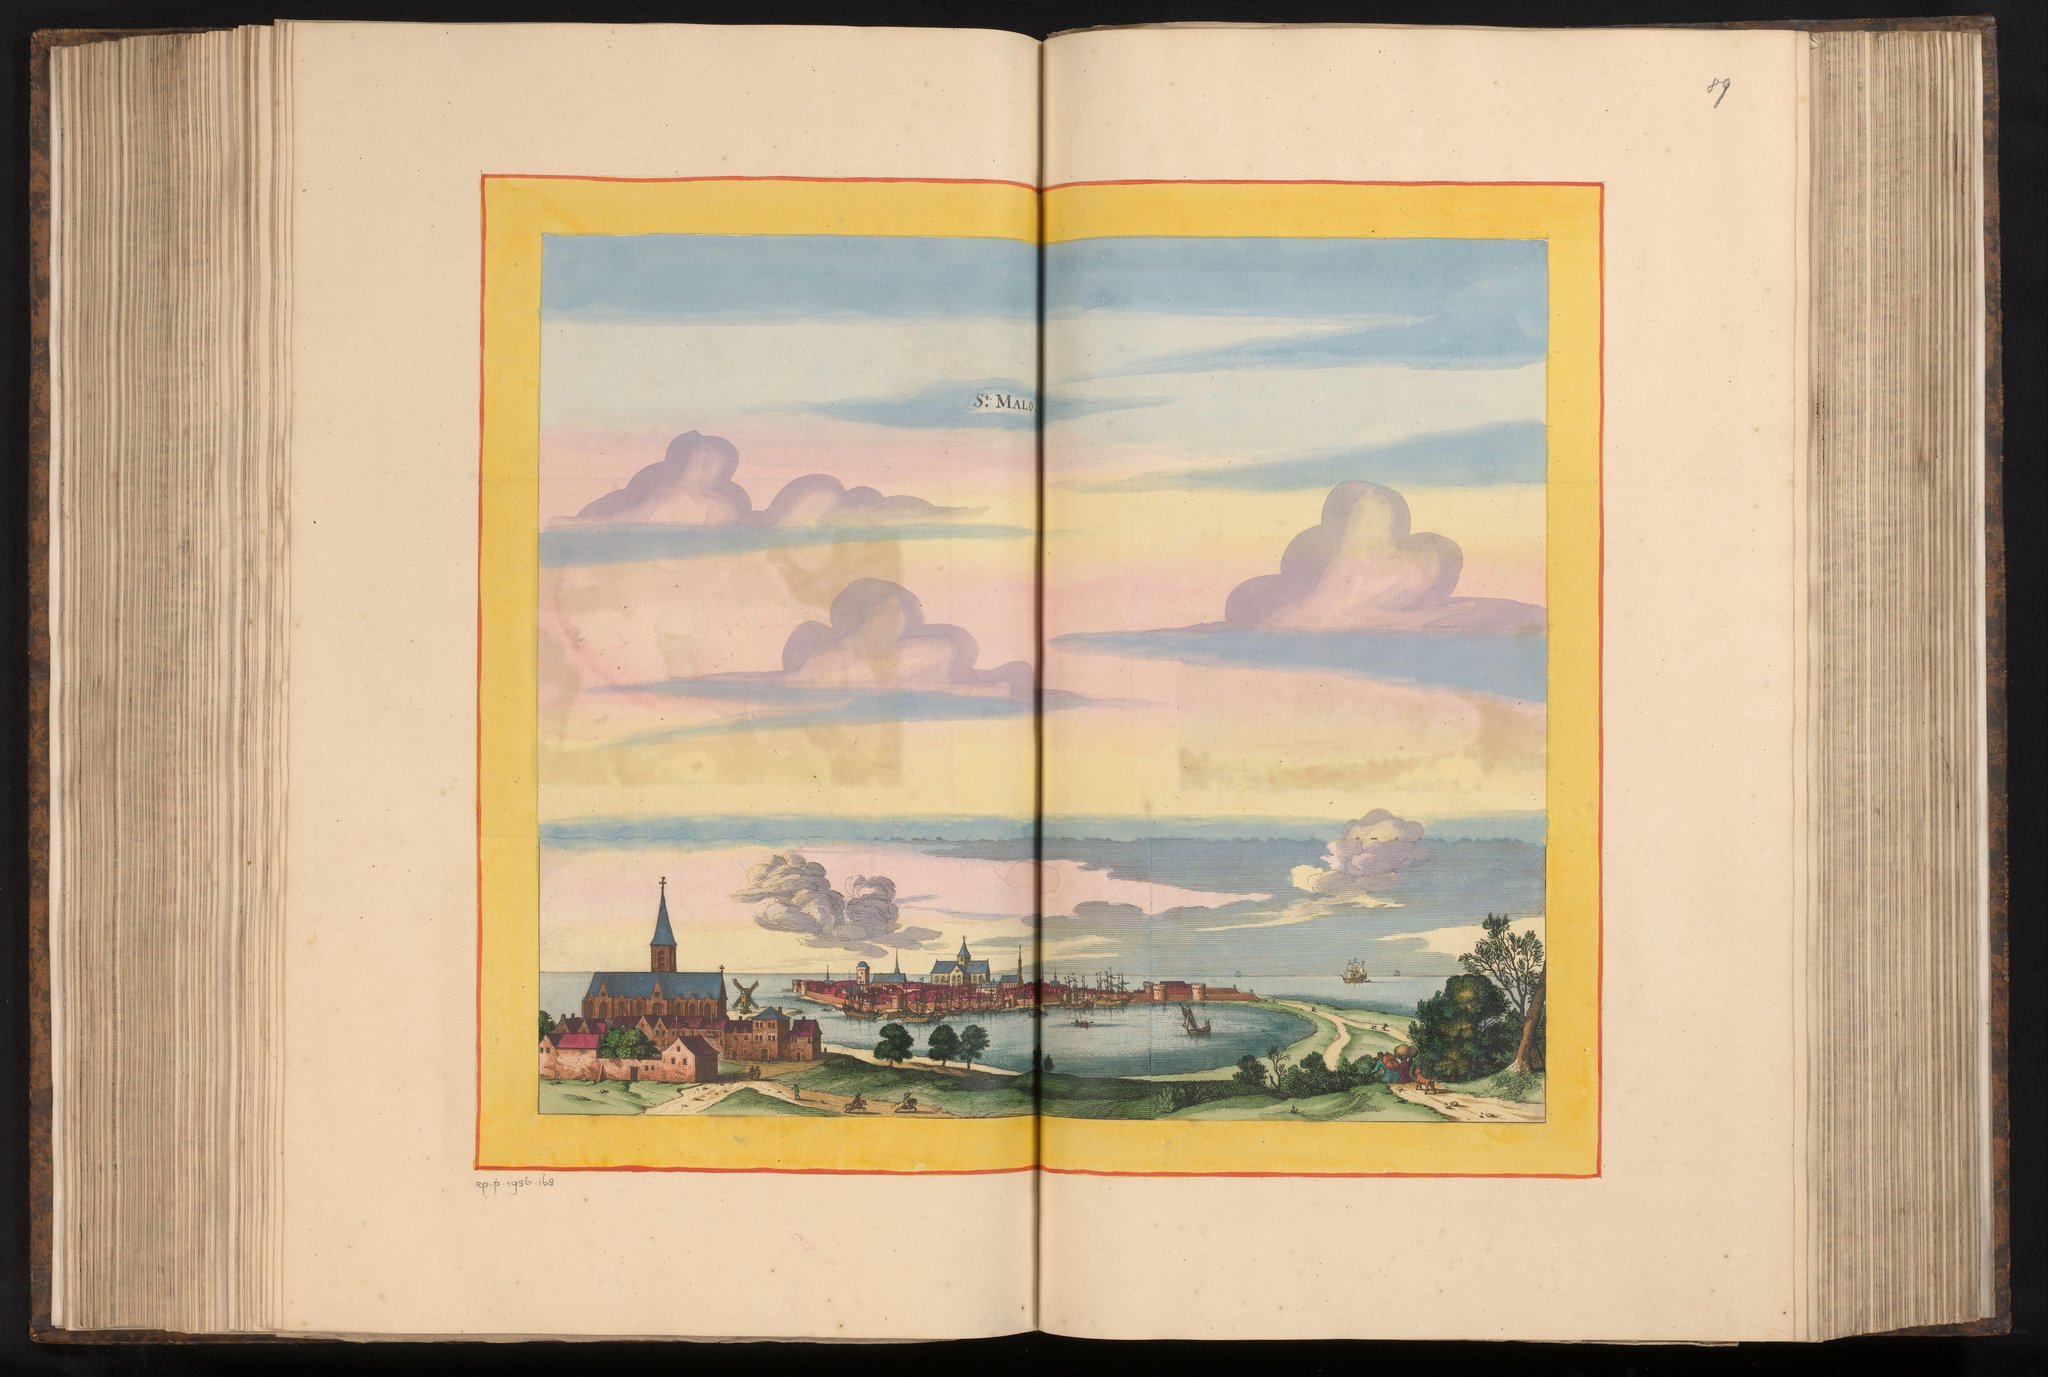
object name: print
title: St. Malo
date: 1661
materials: paper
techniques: engraving, etching, hand coloring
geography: the hague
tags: city-view in general; 'veduta'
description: Prent uit: Zeiller, Martin. Topographia Galliae. 13 dln. Frankfurt: Caspar Merian, 1661, dl. 9, na p. 16. De titel is uit de originele prent gesneden. Boven de gravure is een deel lucht en wolken (bij)geschilderd, waarin de titel gelijmd is. Origineel op één blad gedrukt met het gezicht op Nantes (RP-P-1956-171).